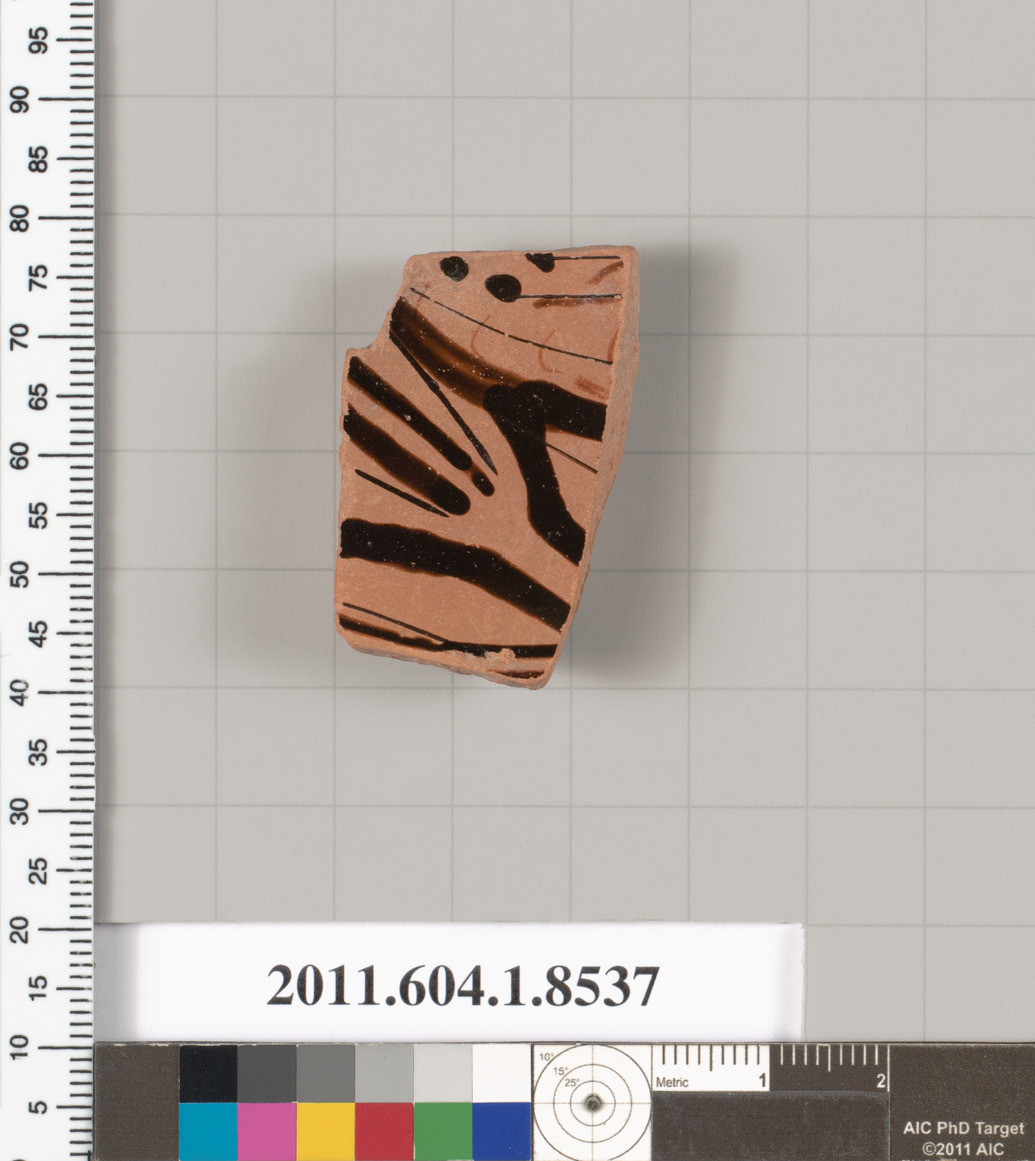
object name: kylix fragment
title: Terracotta fragment of a stemless kylix (drinking cup)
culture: greek, attic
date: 450-440 BCE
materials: terracotta